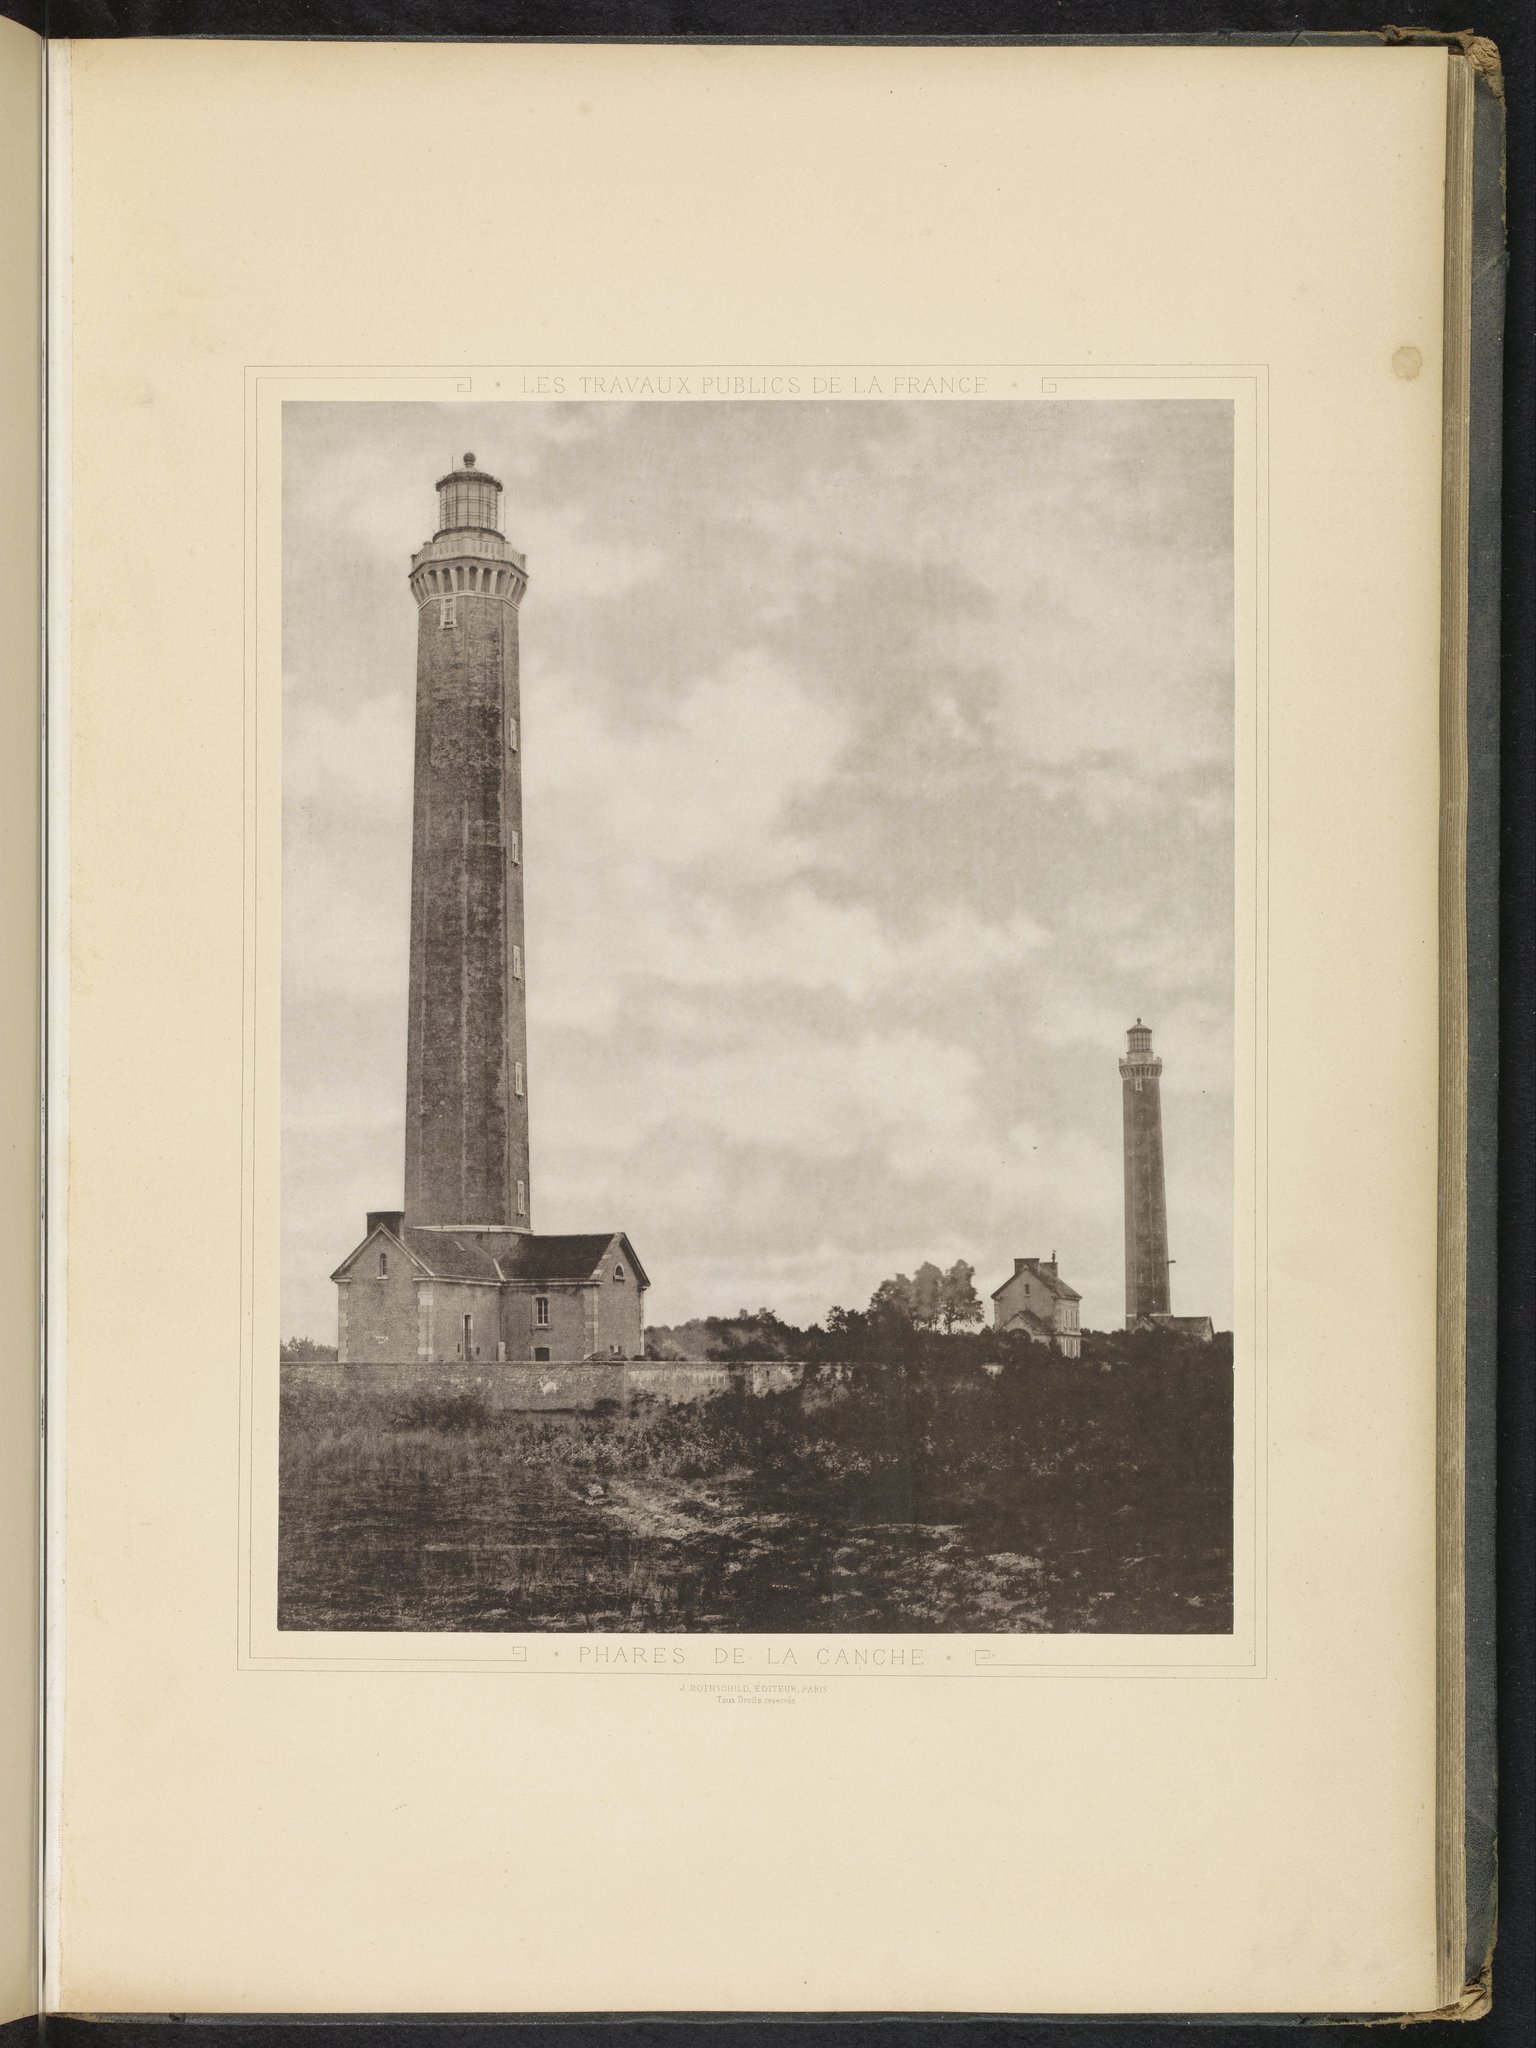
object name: photomechanical print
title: Vuurtorens van La Canche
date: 1873-1883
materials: paper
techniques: photograph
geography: france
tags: lighthouse, lightship